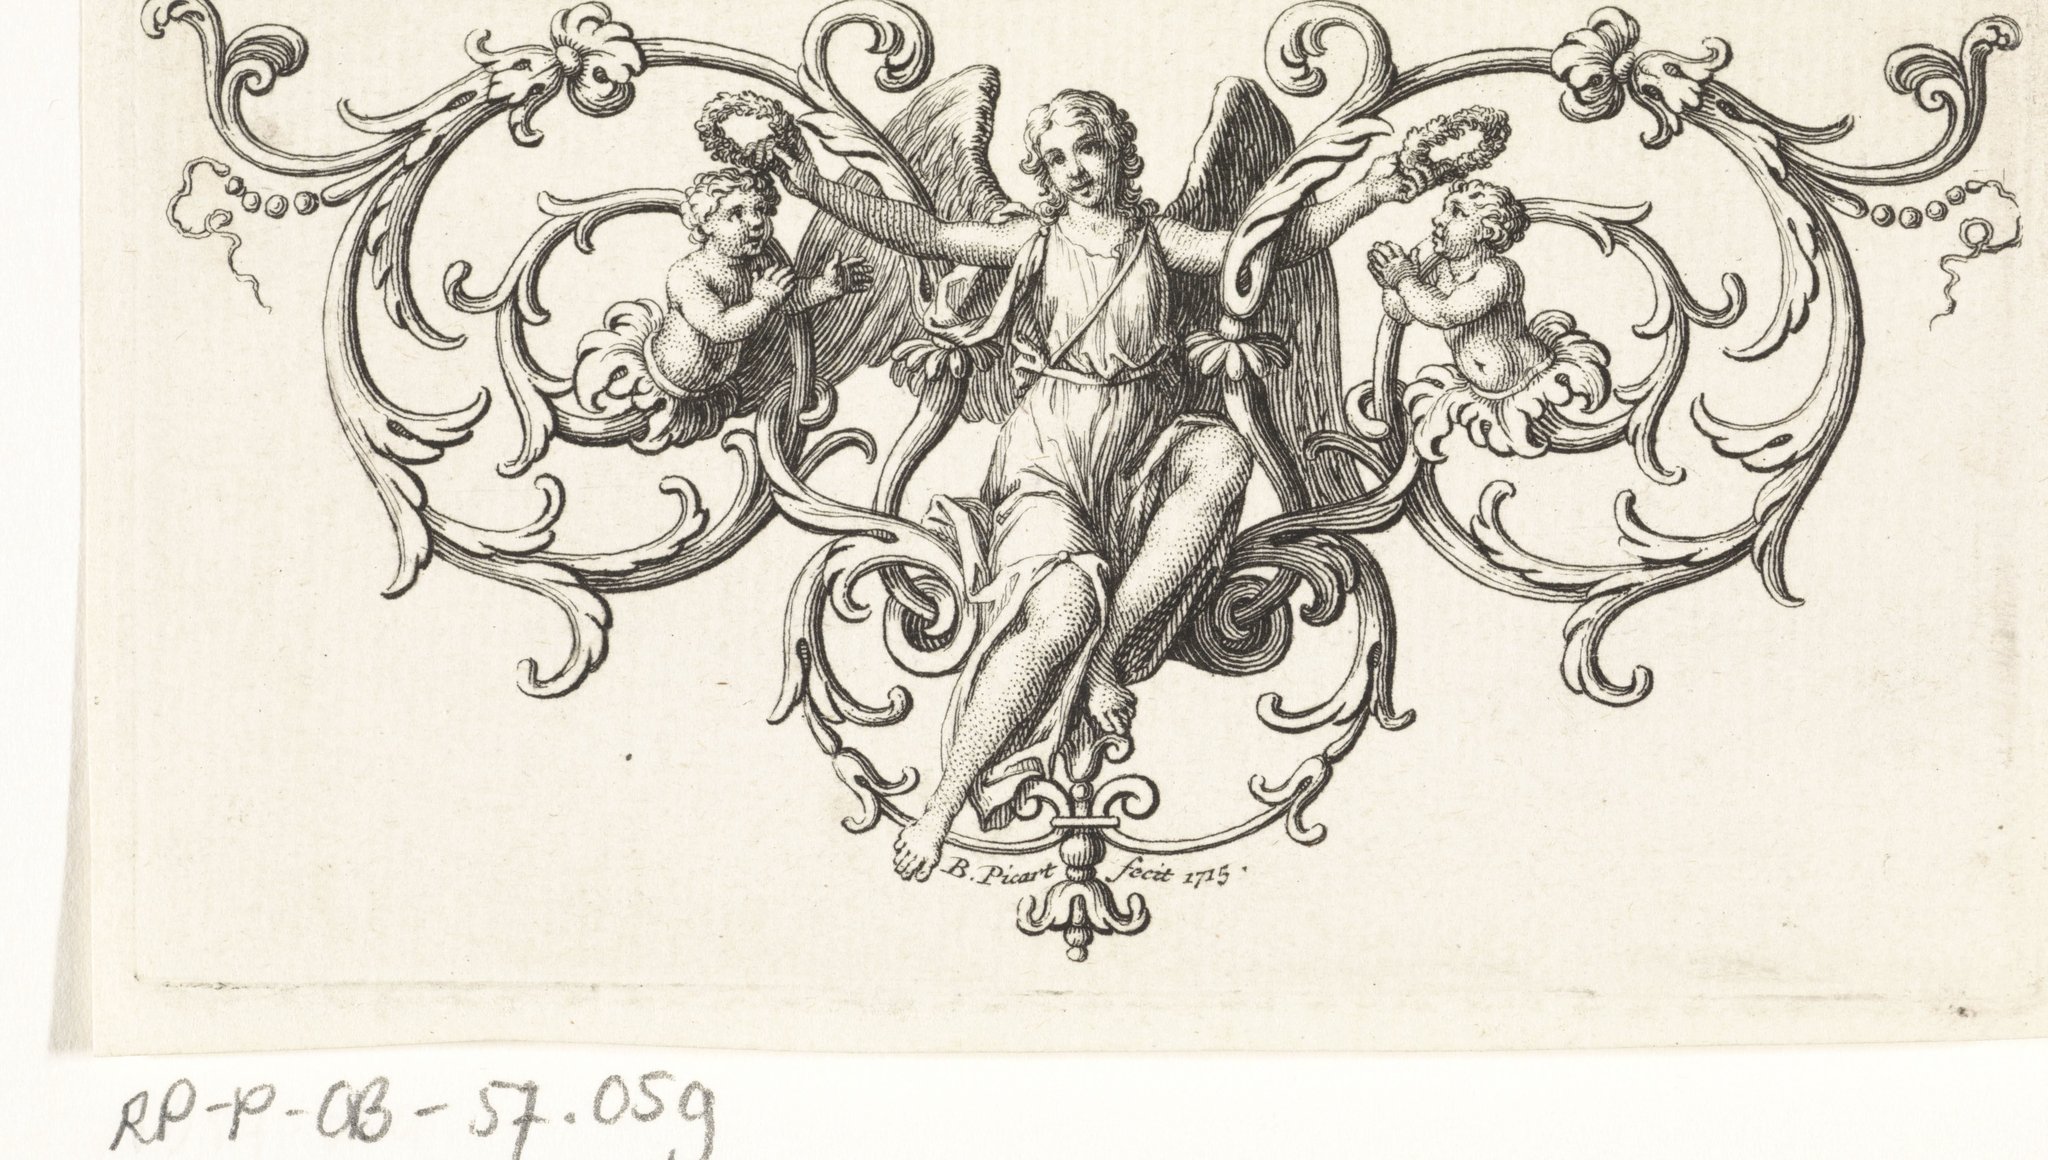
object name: print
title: Engel kroont twee putti omgeven door ornamenten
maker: bernard picart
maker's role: draughtsman, print maker, publisher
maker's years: 1673-1733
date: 1715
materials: paper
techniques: engraving, etching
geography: amsterdam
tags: ornaments ~ art, crowning with laurel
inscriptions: collector's mark: Lugt 2228